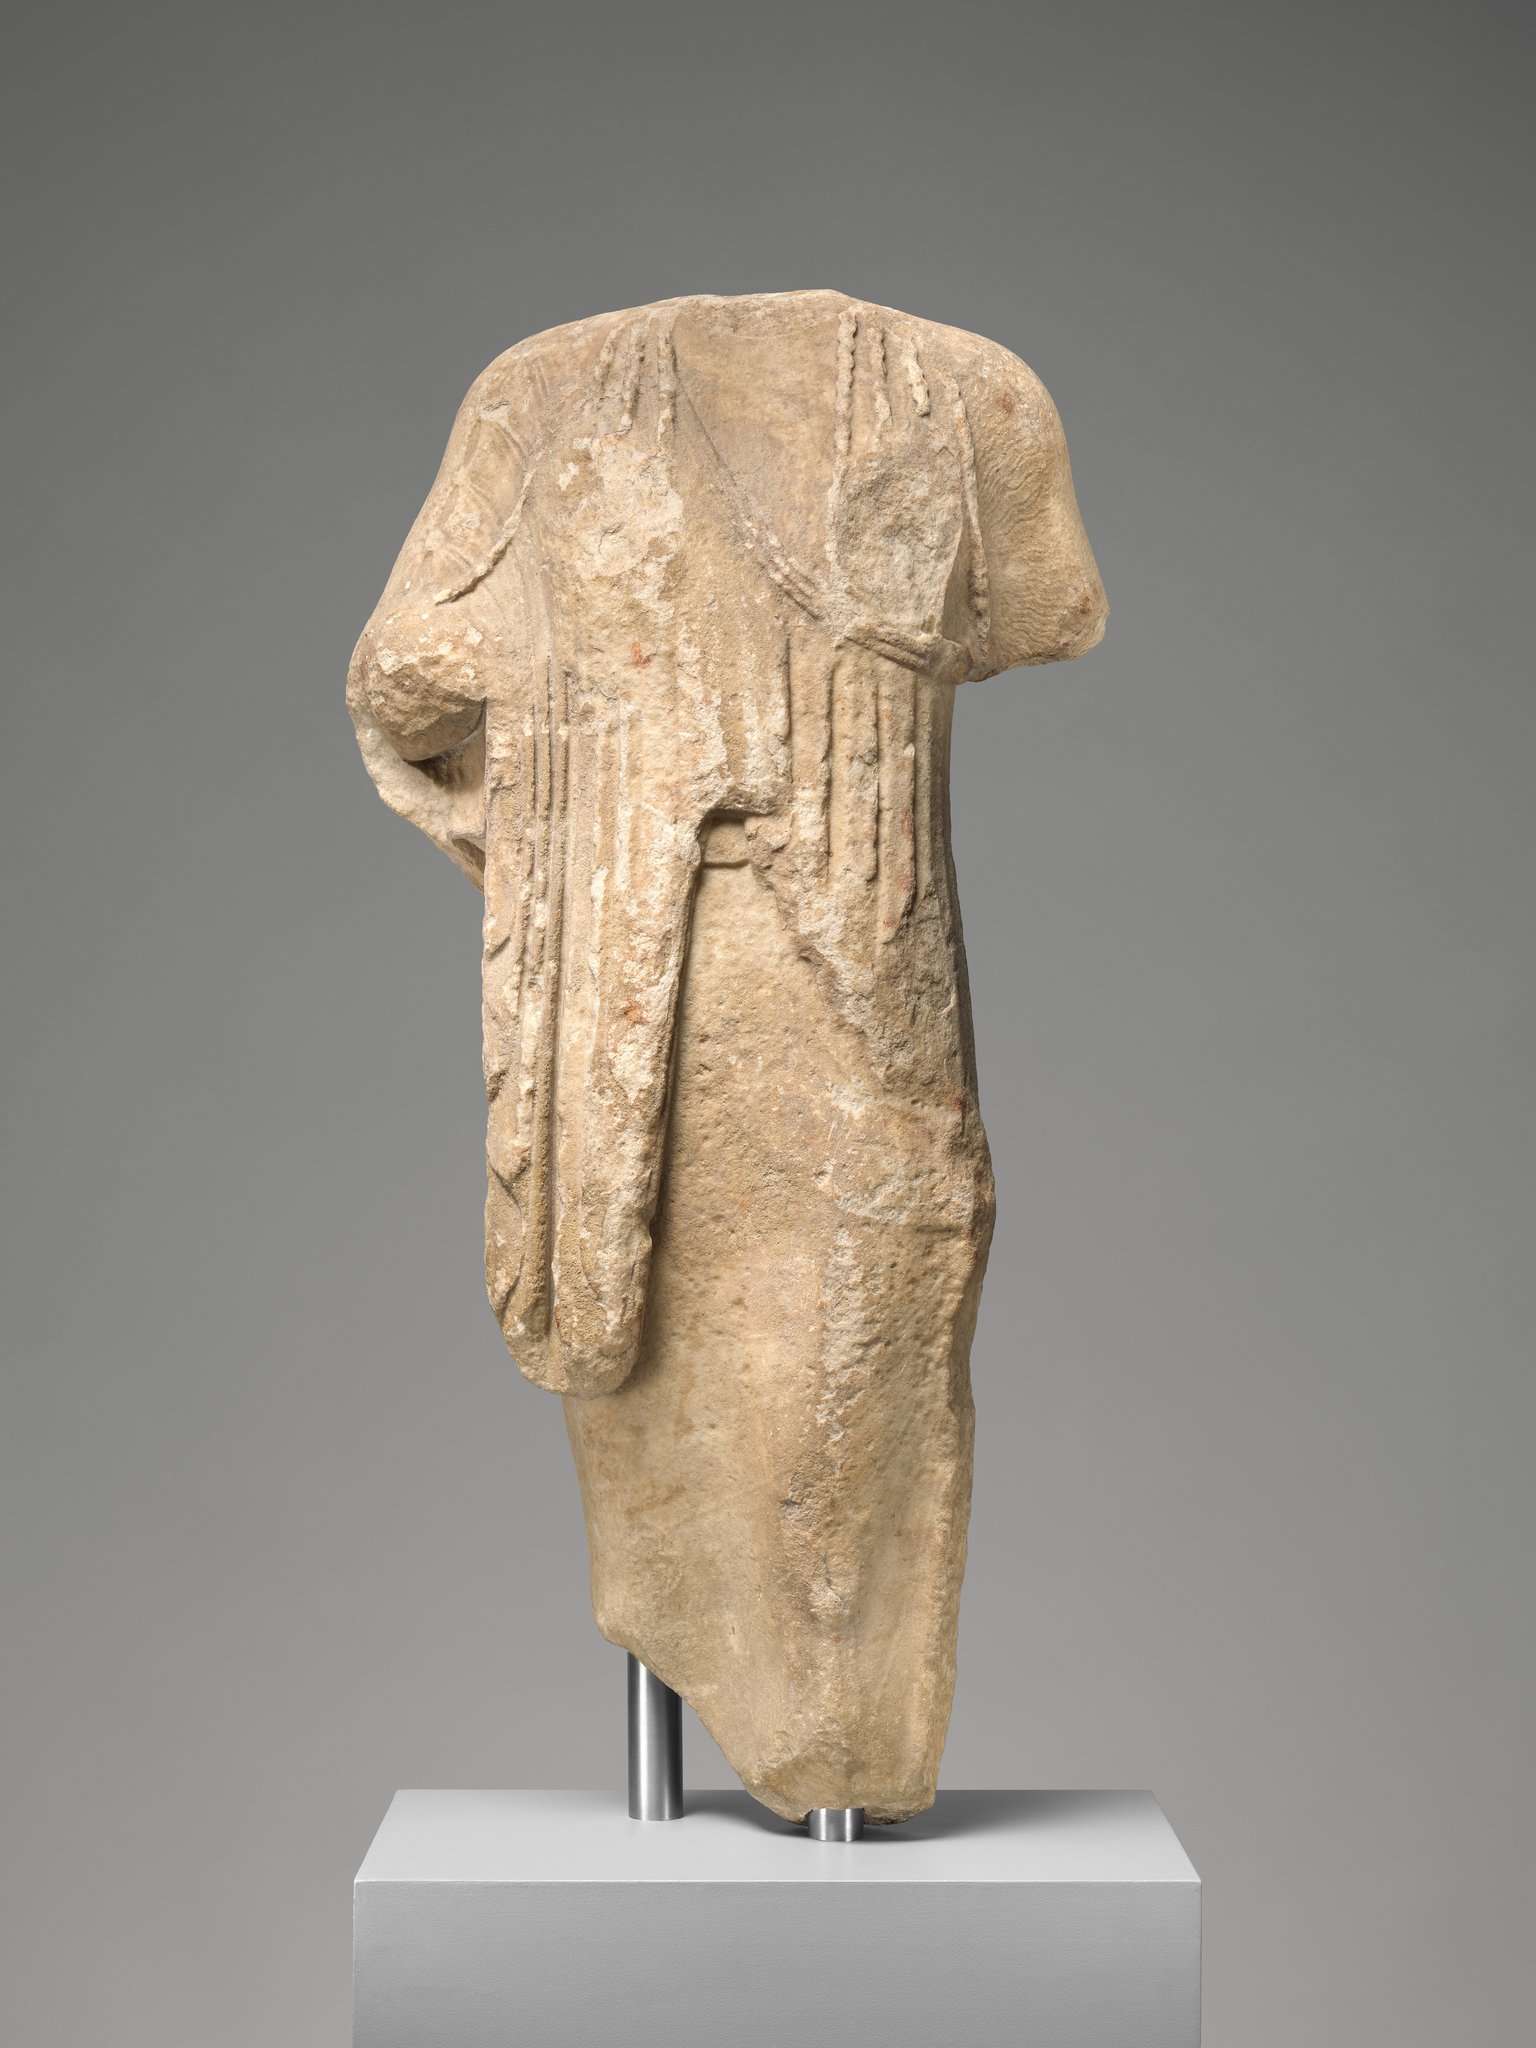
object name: statue of a kore maiden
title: Marble statue of a kore (maiden)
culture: greek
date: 534-501 BCE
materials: marble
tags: women